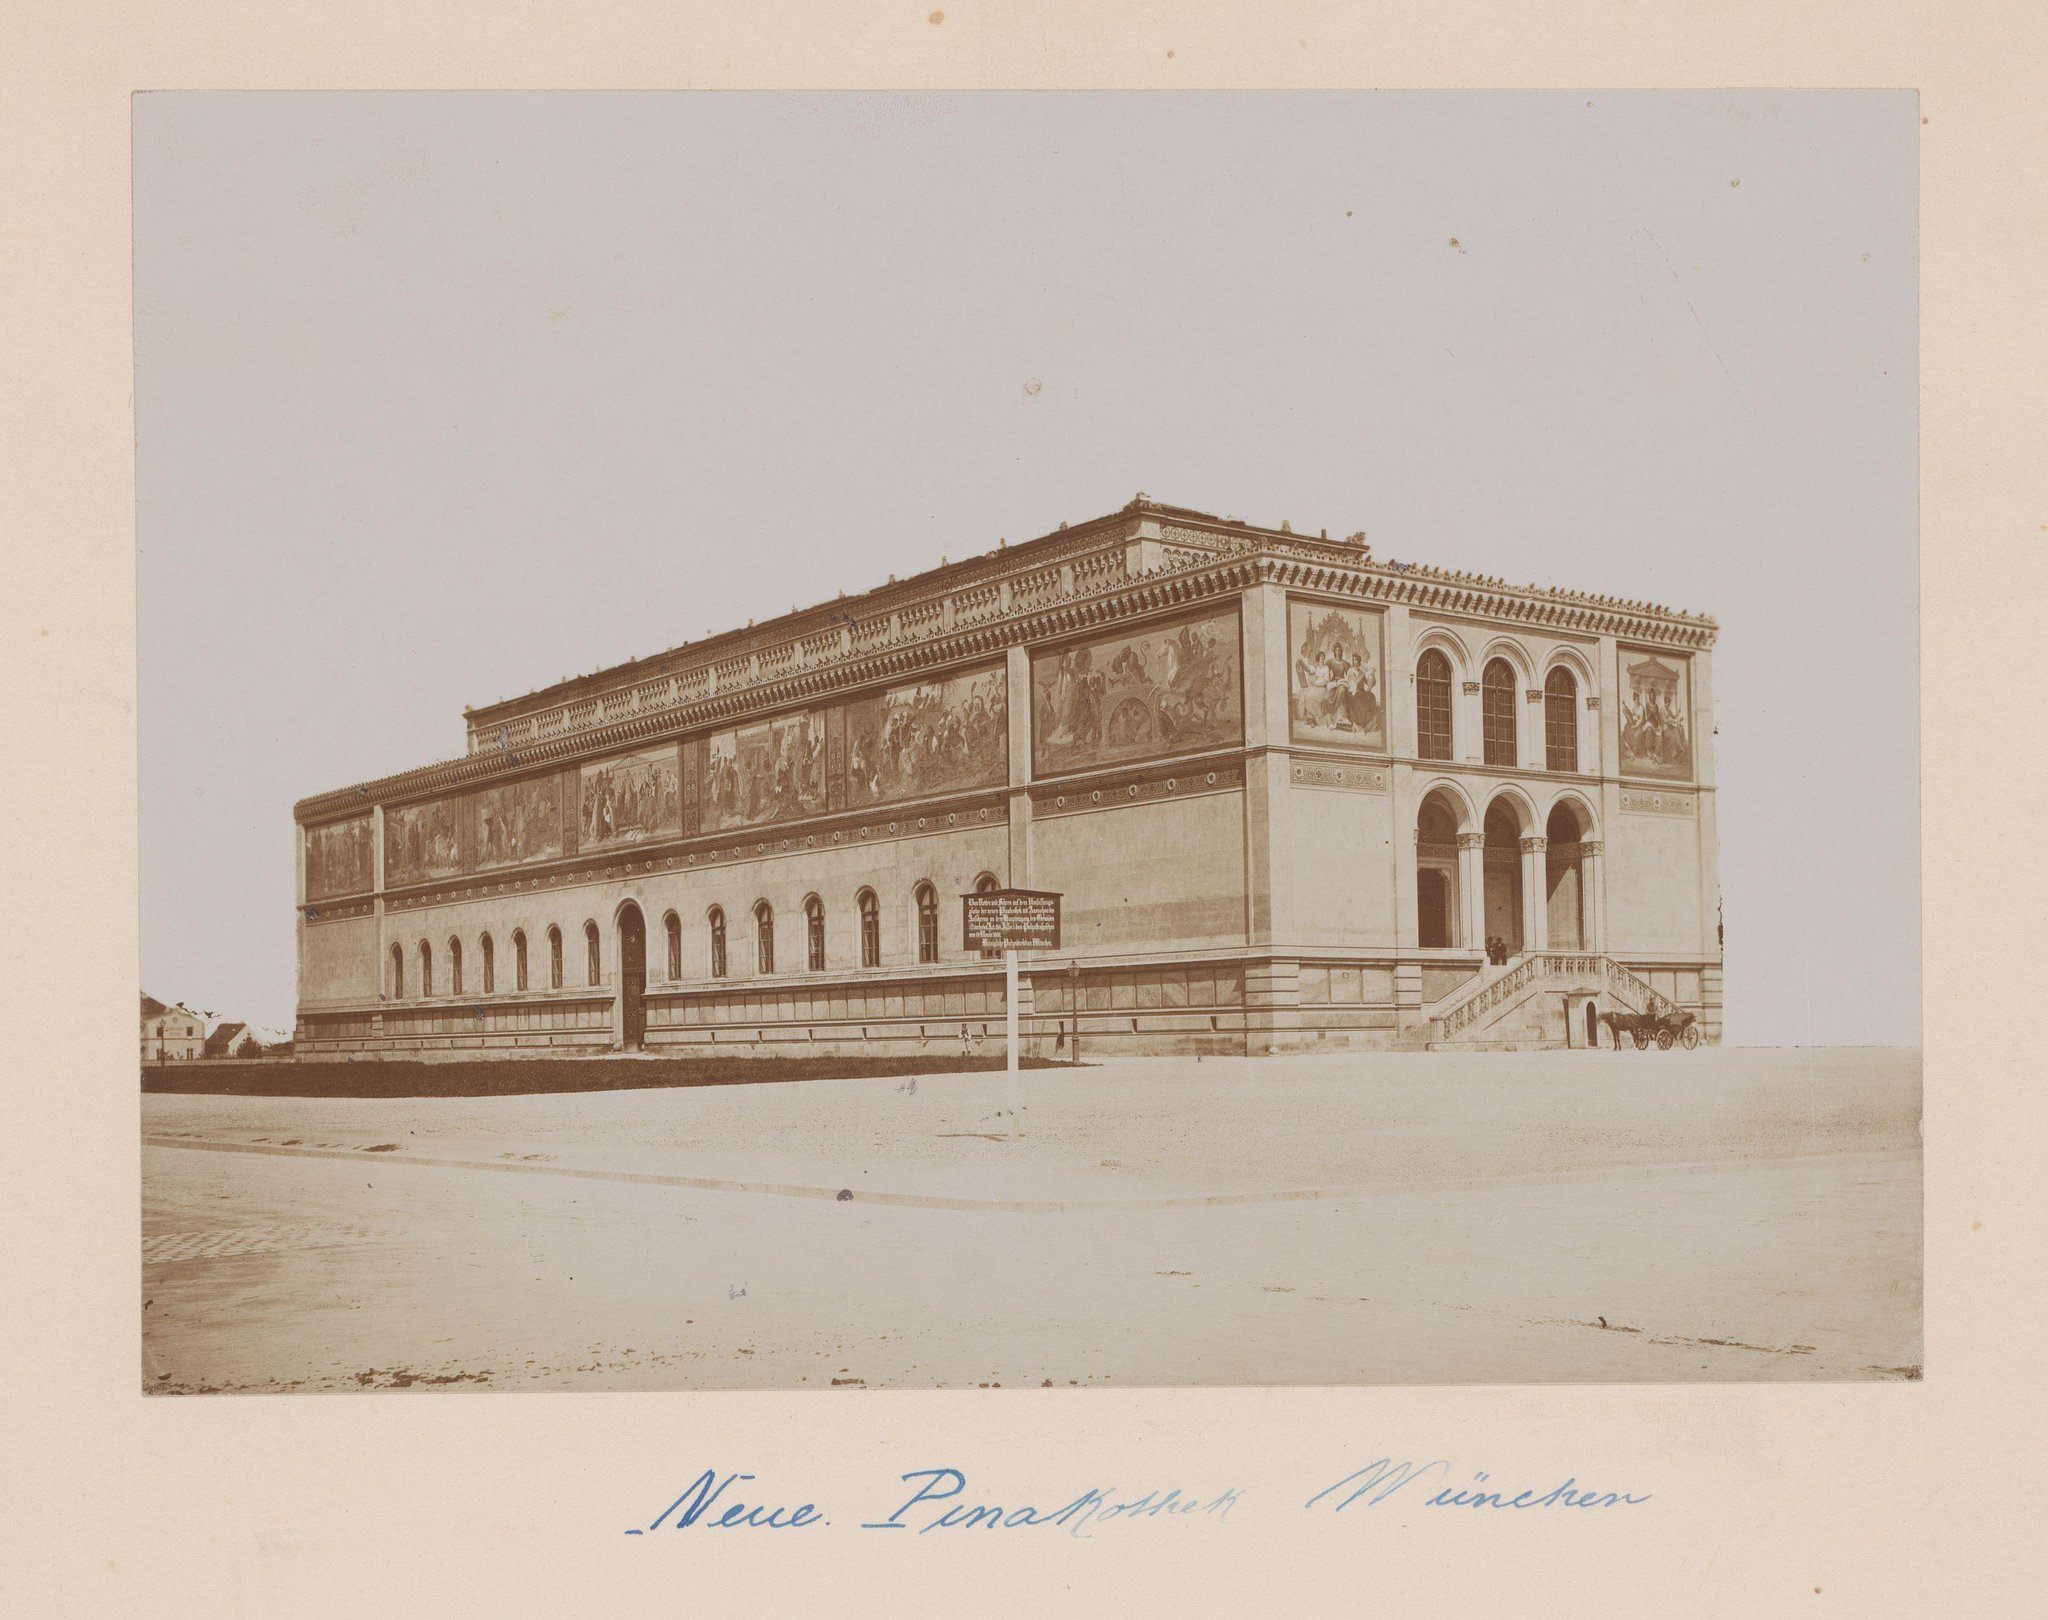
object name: photograph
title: Neue Pinakothek, München, Duitsland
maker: Anonymous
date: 1880-1910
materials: cardboard, photographic support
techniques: collodion silver print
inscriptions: inscription: ‘Neue Pinakothek München’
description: Aanzicht van links vóór op de Neue Pinakothek. Dit museum voor tegenwoordig 18e en 19e-eeuwse kunst werd in 1853 door Lodewijk I gesticht, die daar, evenals in de tegenover liggende Alte Pinakothek, zijn kunstverzameling aan de openbaarheid wilde tonen. In WO II volledig verwoest en gesloopt. Tussen 1975-1981 is de Neue Pinakothek herbouwd naar ontwerp van Alexander Freiherr von Branca.